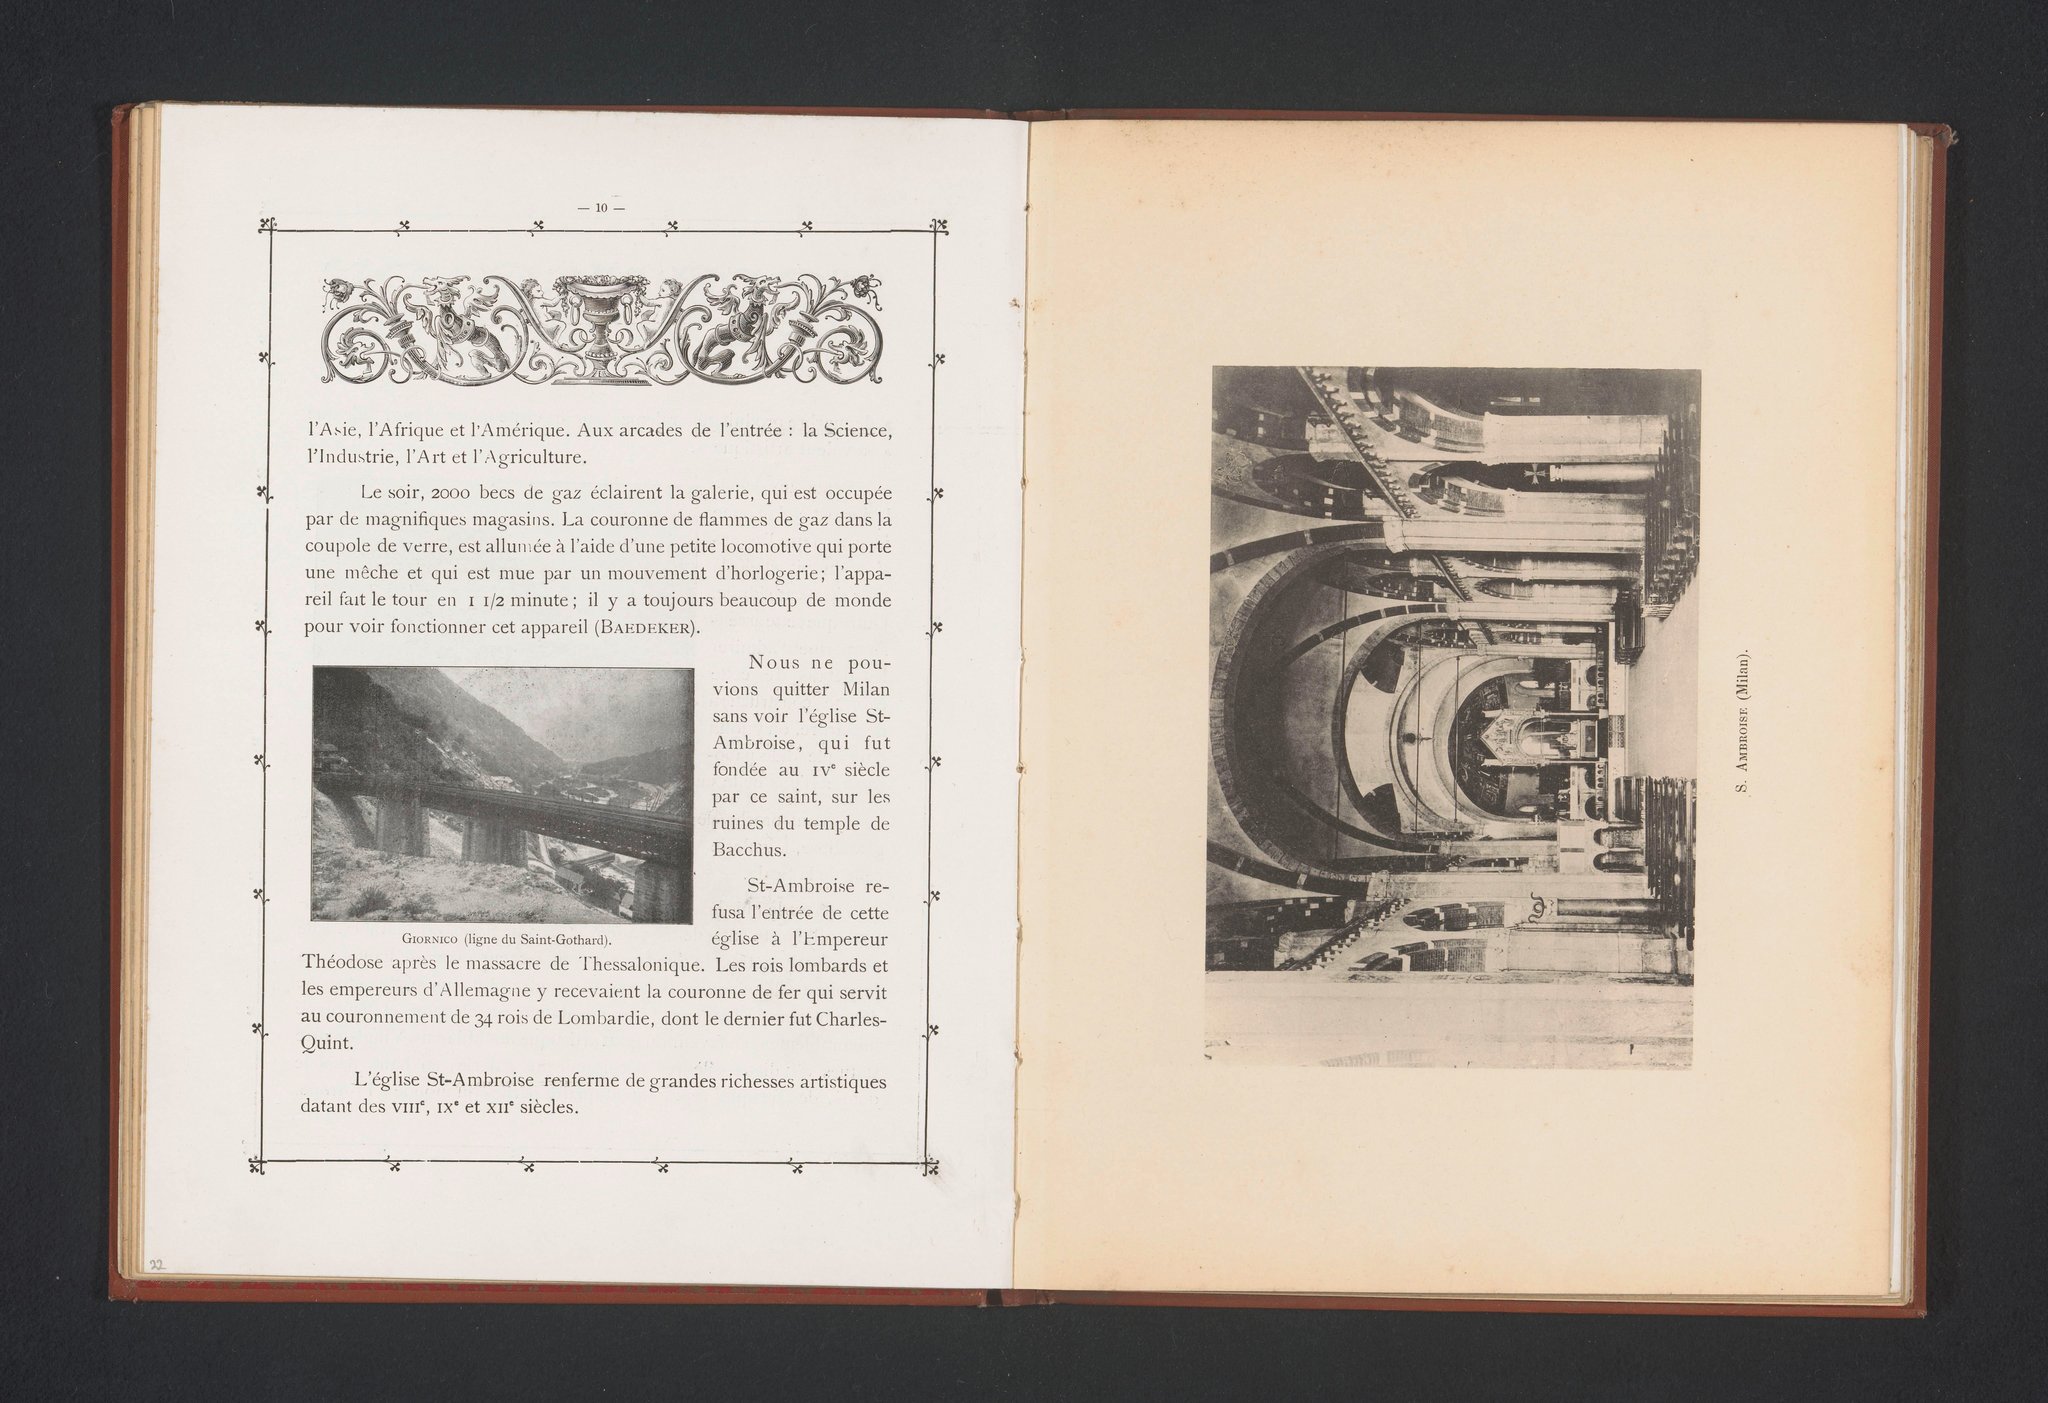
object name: page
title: Giornico (ligne du Saint-Gothard)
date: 1893-1898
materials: paper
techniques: autotype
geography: giornico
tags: dale, valley, mountains